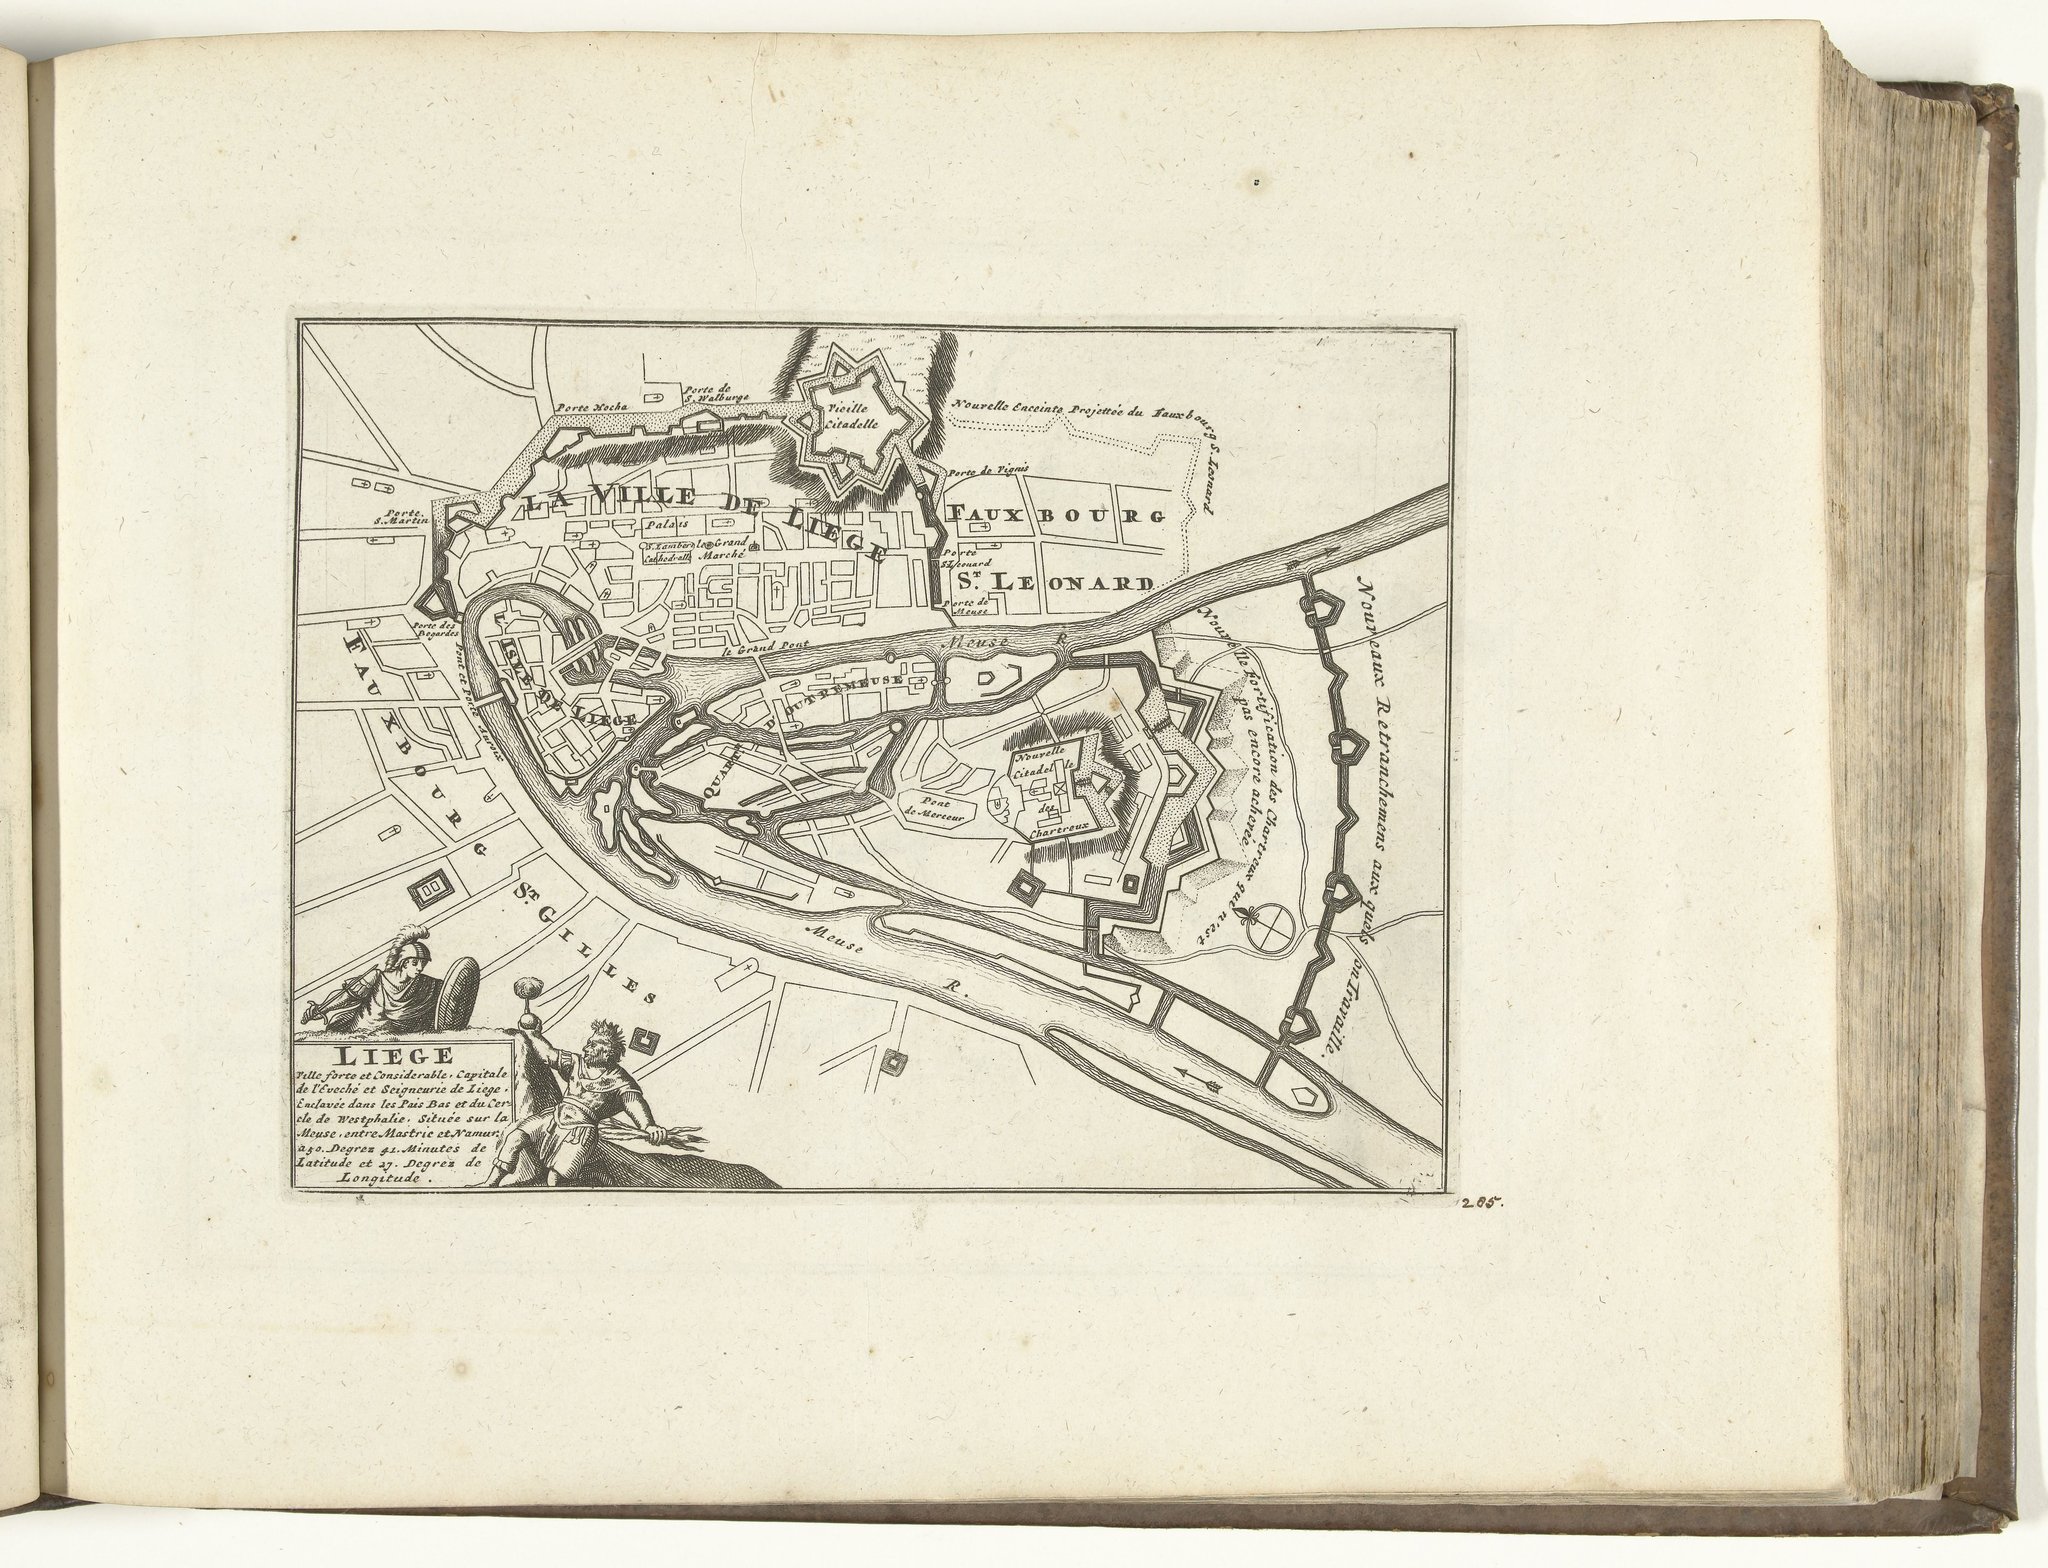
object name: area plan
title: Liege, ville forte et considerable (...)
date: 1726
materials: paper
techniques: etching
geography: leiden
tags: fortress, maps of cities, liège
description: Plattegrond van de verdedigingswerken om Luik. Plaat nr. 285 in deel XII van het prentwerk: Les Forces de l'Europe, Asie, Afrique et Amerique ... Comme aussi les Cartes des Côtes de France et d'Espagne uit 1726, dit tweede deel met 271 met de hand genummerde platen van vermaarde sterke steden en vestingen in het kader van de Spaanse Successieoorlog 1701-1713. Voor het merendeel zijn deze platen gekopieerd naar de anonieme Franse platen van vermaarde sterke steden en vestingen: in Les forces de l'Europe en in: Le theatre de la guerre, dans les Pays-Bas, beide oorspronkelijk uitgegeven door Nicolas de Fer te Parijs (1693-1697) in het kader van de Negenjarige Oorlog. Titel en opschriften in het Frans. Rechtsonder sporen van het weggepolijste nummer: 27.